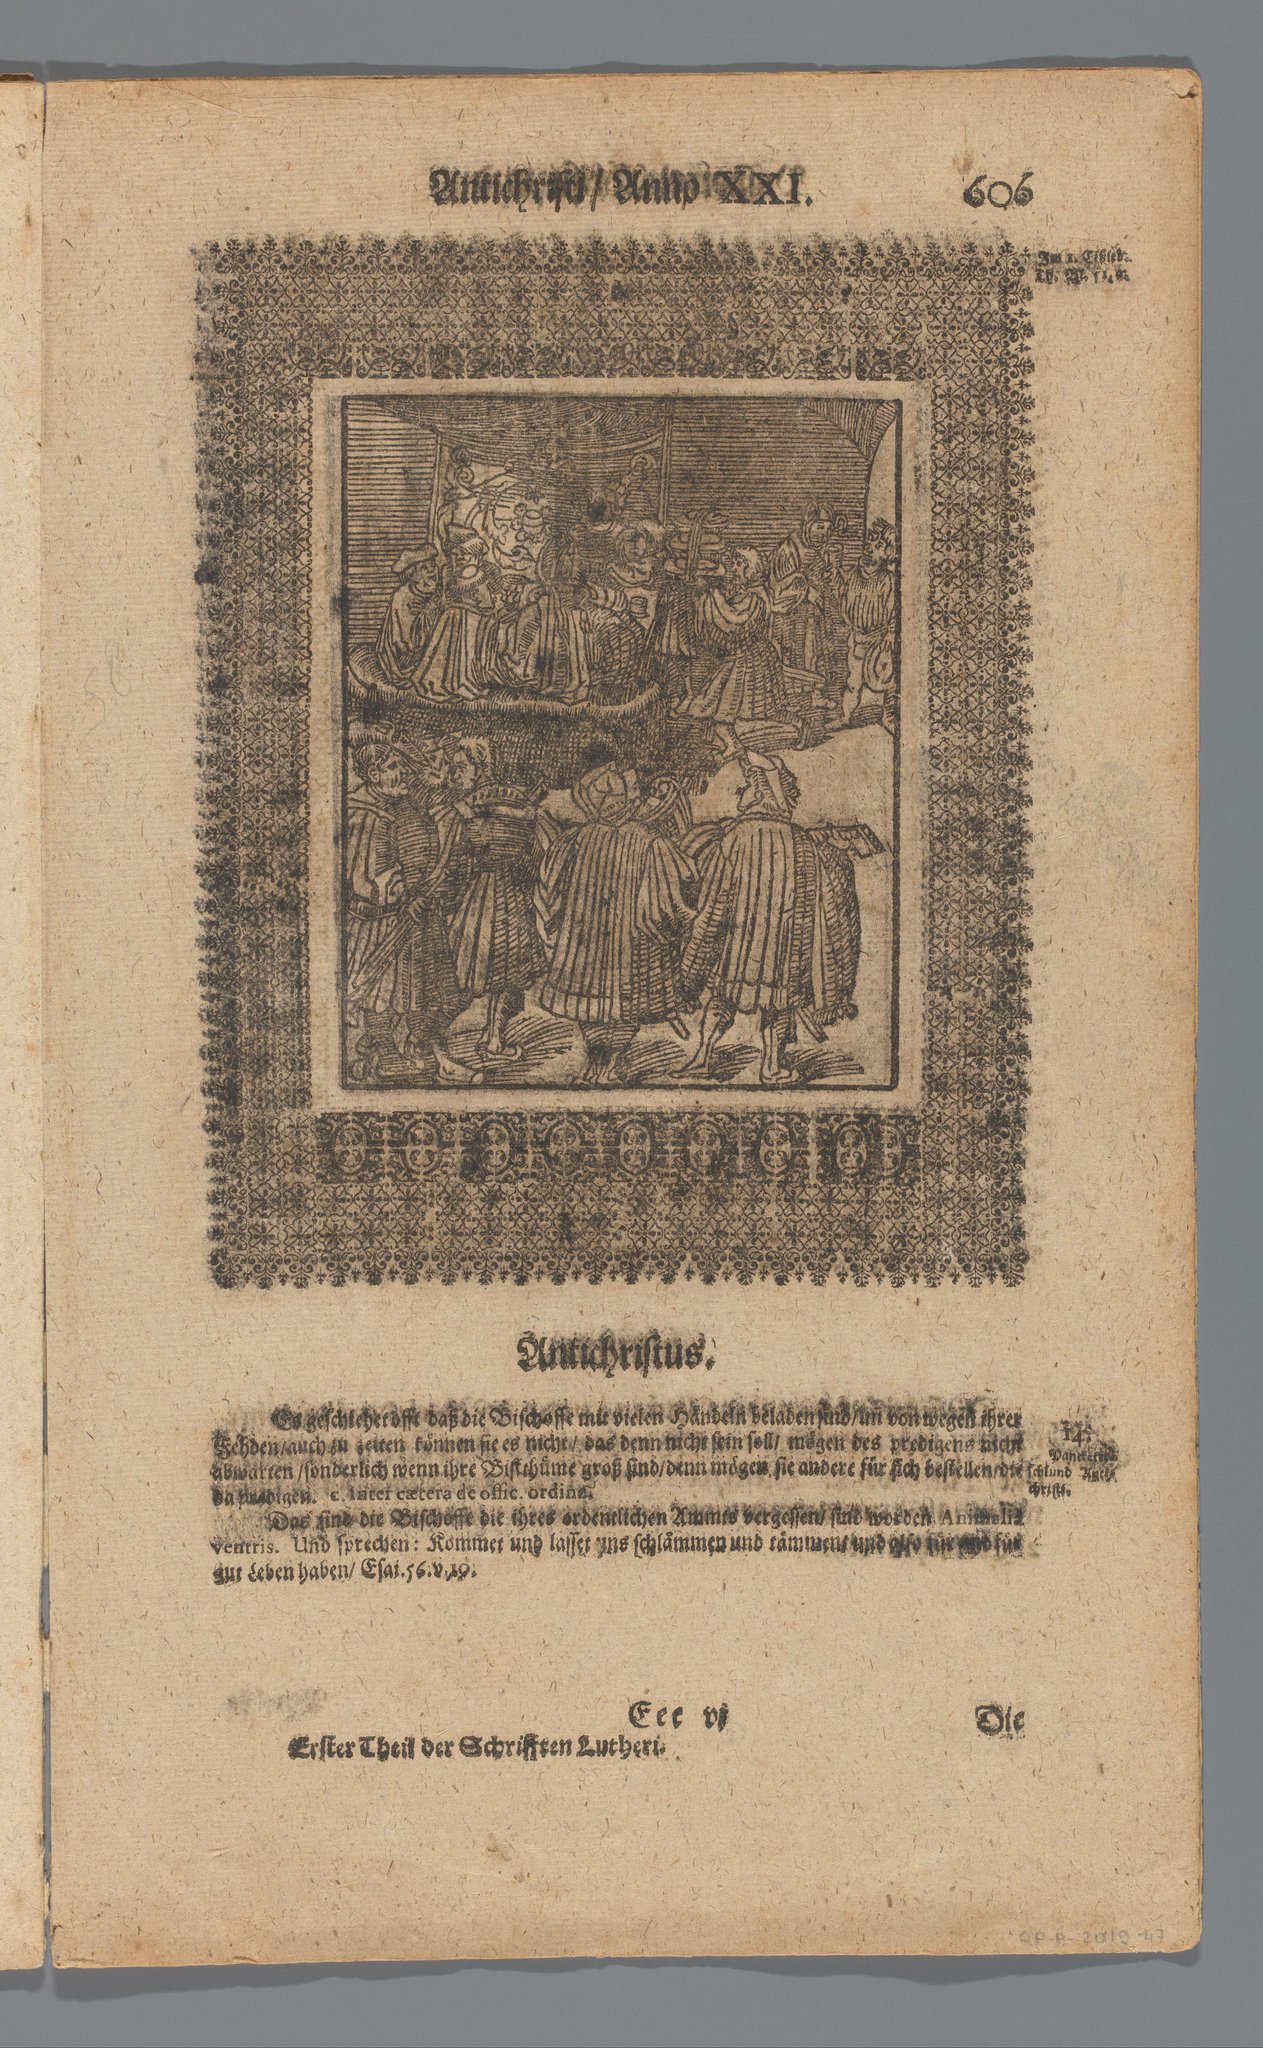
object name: print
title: Paus en geestelijken aan feestmaal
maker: monogrammist gk (prentmaker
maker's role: print maker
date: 1661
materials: paper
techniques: letterpress printing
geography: europe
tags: the richness of the church opposed to christ's humility, celebration meal, feast, banquet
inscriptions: collector's mark: Lugt 2228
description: Paus en geestelijken aan feestmaal. Tegenstelling over voedsel. Spiegelbeeldige kopie naar de prent van Lucas Cranach in het pamflet 'Passional Christi und Antichristi' van Martin Luther uit 1521, bladzijde 606 uit een 17e-eeuwse uitgave. De reeks van dertien paar houtsneden geeft de tegenstellingen weer tussen de nederigheid en onbaatzuchtigheid van Christus enerzijds, en de trots en hebzucht van de paus anderzijds.